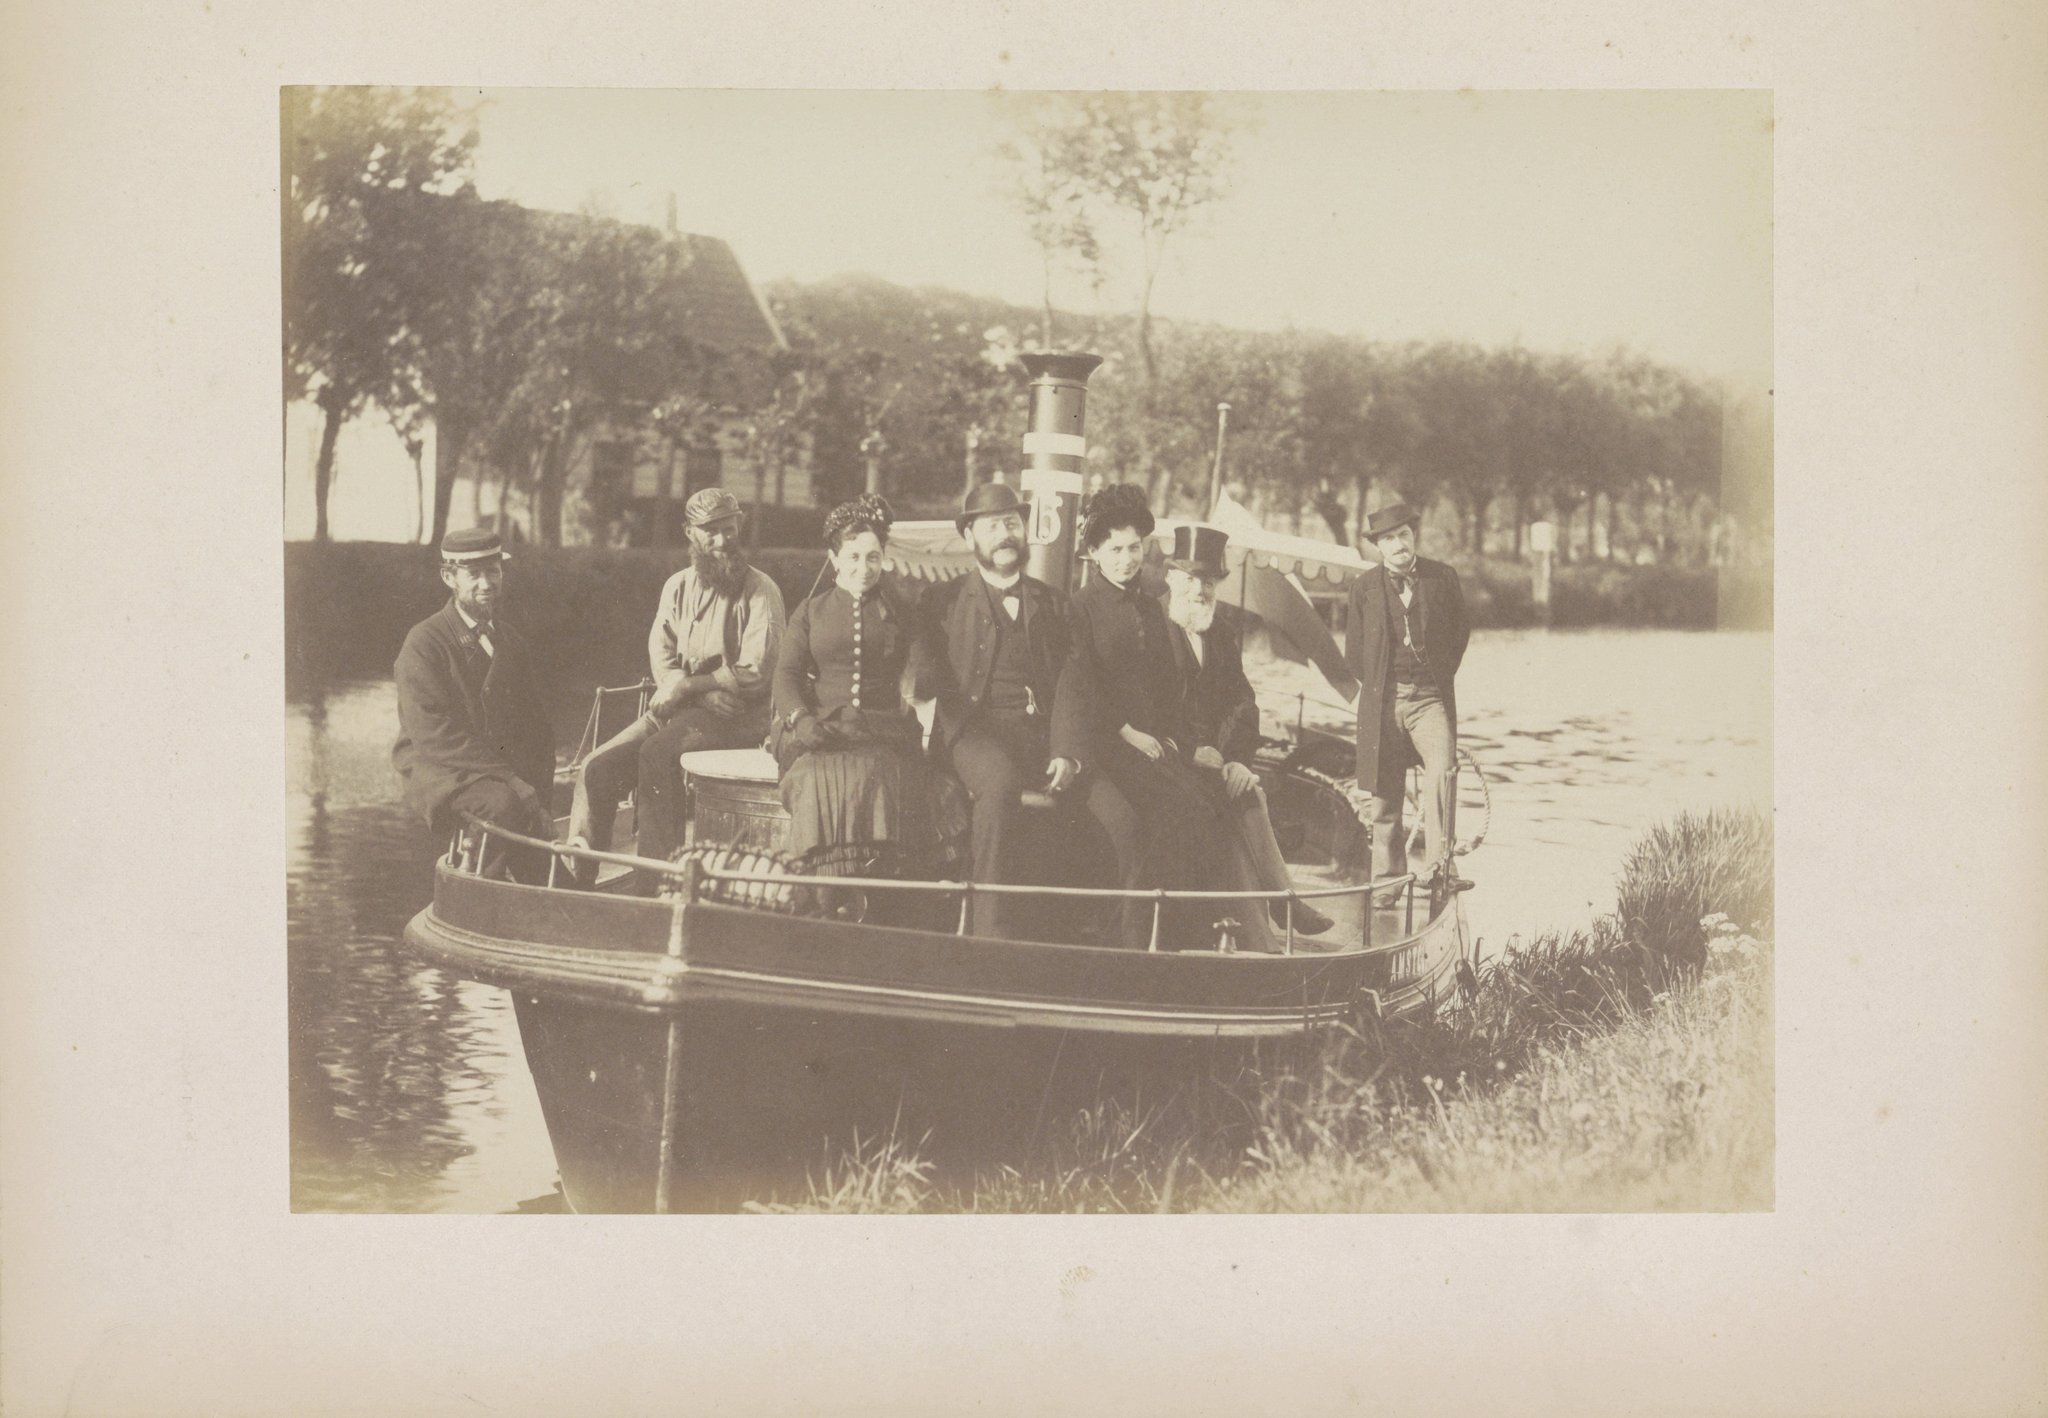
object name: photograph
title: ((...)) / (.) marken / l'amstel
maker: Anonymous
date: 1885-1900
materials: paper, photographic support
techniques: albumen print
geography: netherlands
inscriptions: annotation: ‘(...) / (.) marken / l'amstel’